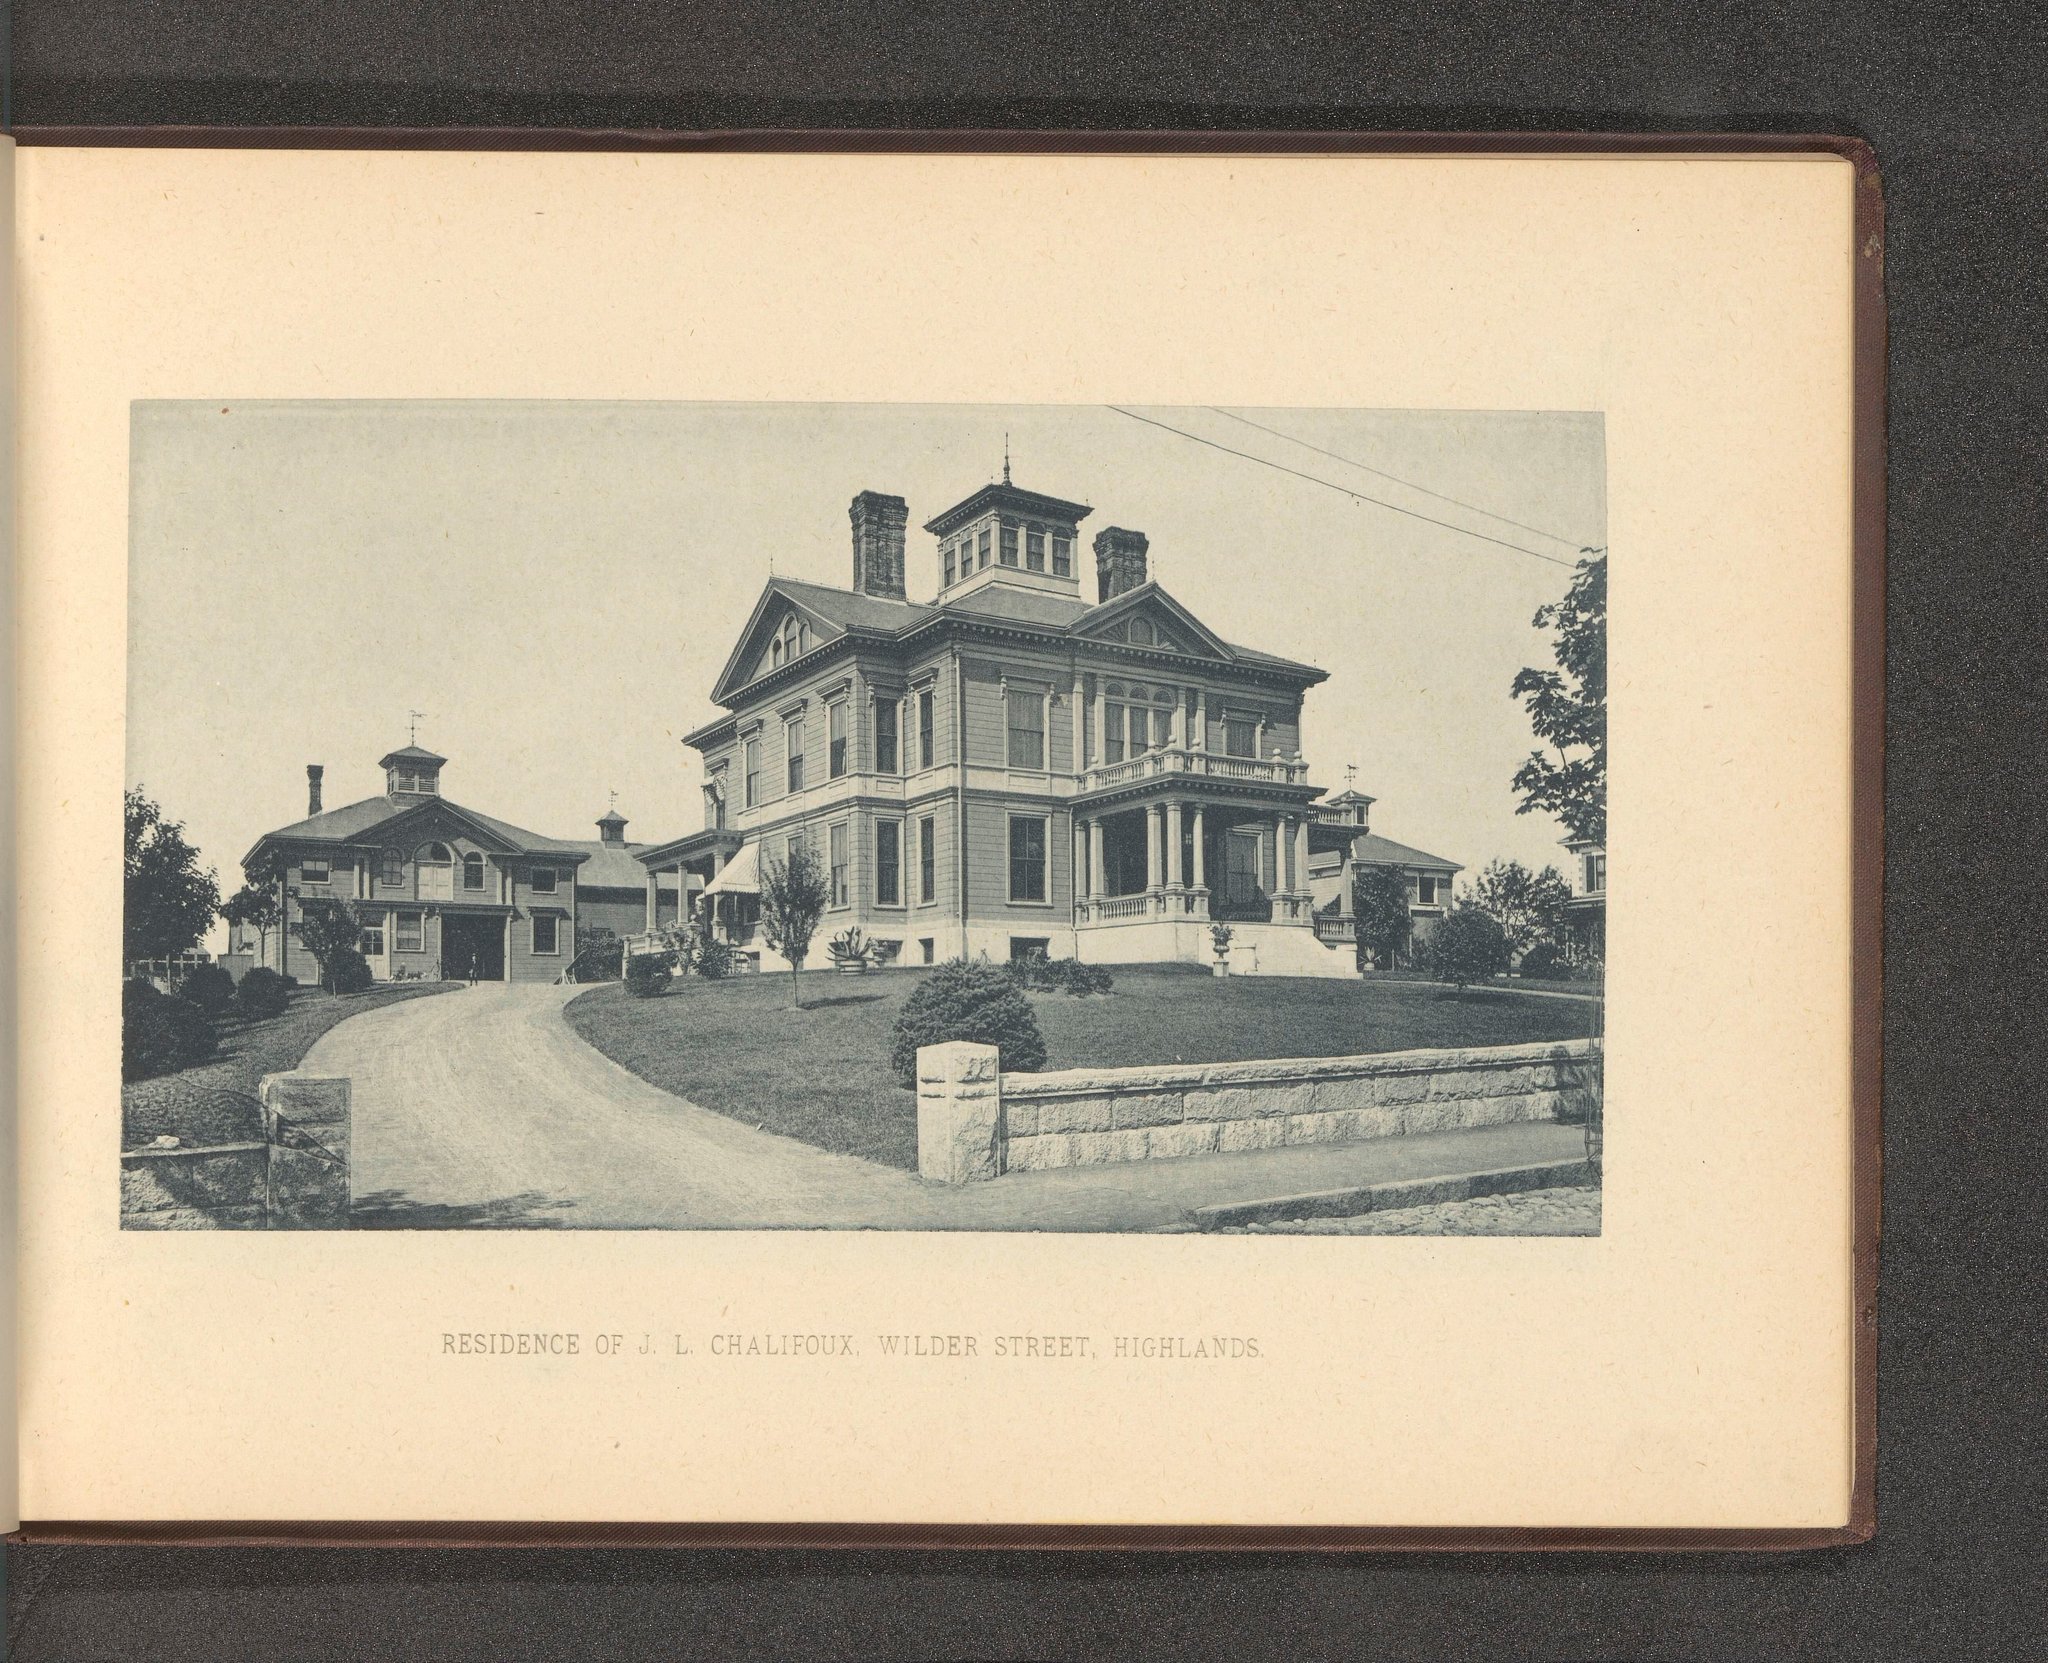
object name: page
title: Residence of J.L. Chalifoux, Wilder street, Highlands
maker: Anonymous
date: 1887-1892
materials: paper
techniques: photograph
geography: lowell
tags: villa, façade (of house or building)